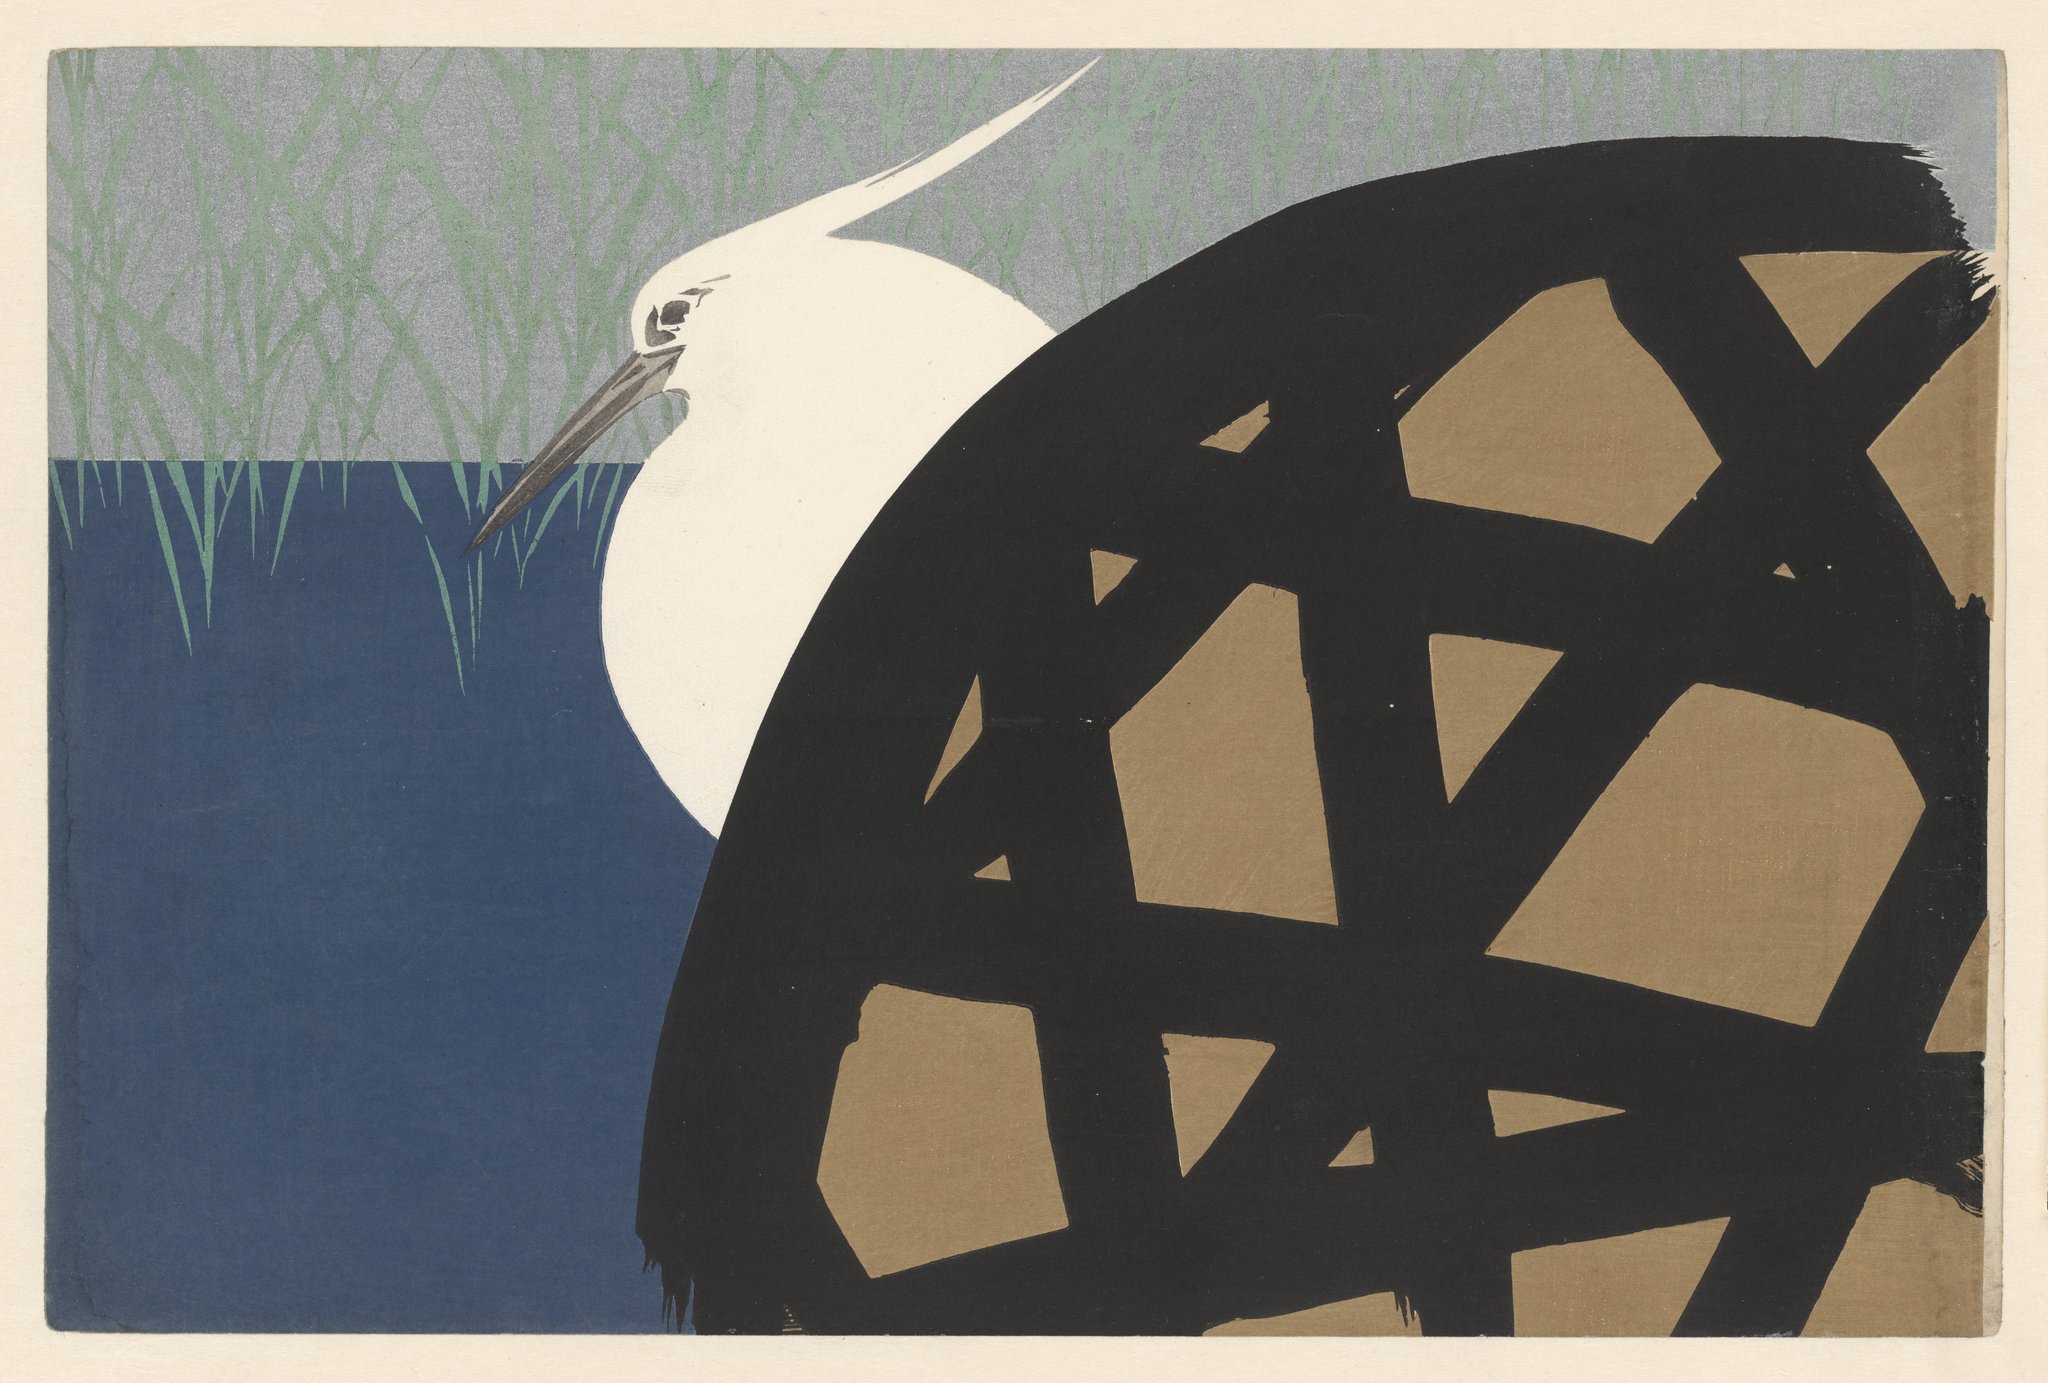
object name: print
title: White Heron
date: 1909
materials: paper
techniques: woodcut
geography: kyoto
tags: shore-birds and wading-birds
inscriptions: collector's mark: Lugt 2228, collector's mark: Lugt 2760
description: Witte reiger, half verscholen achter een bruin-zwart object. Groene waterplanten, tegen een blauwe en zilverkleurige achtergrond.